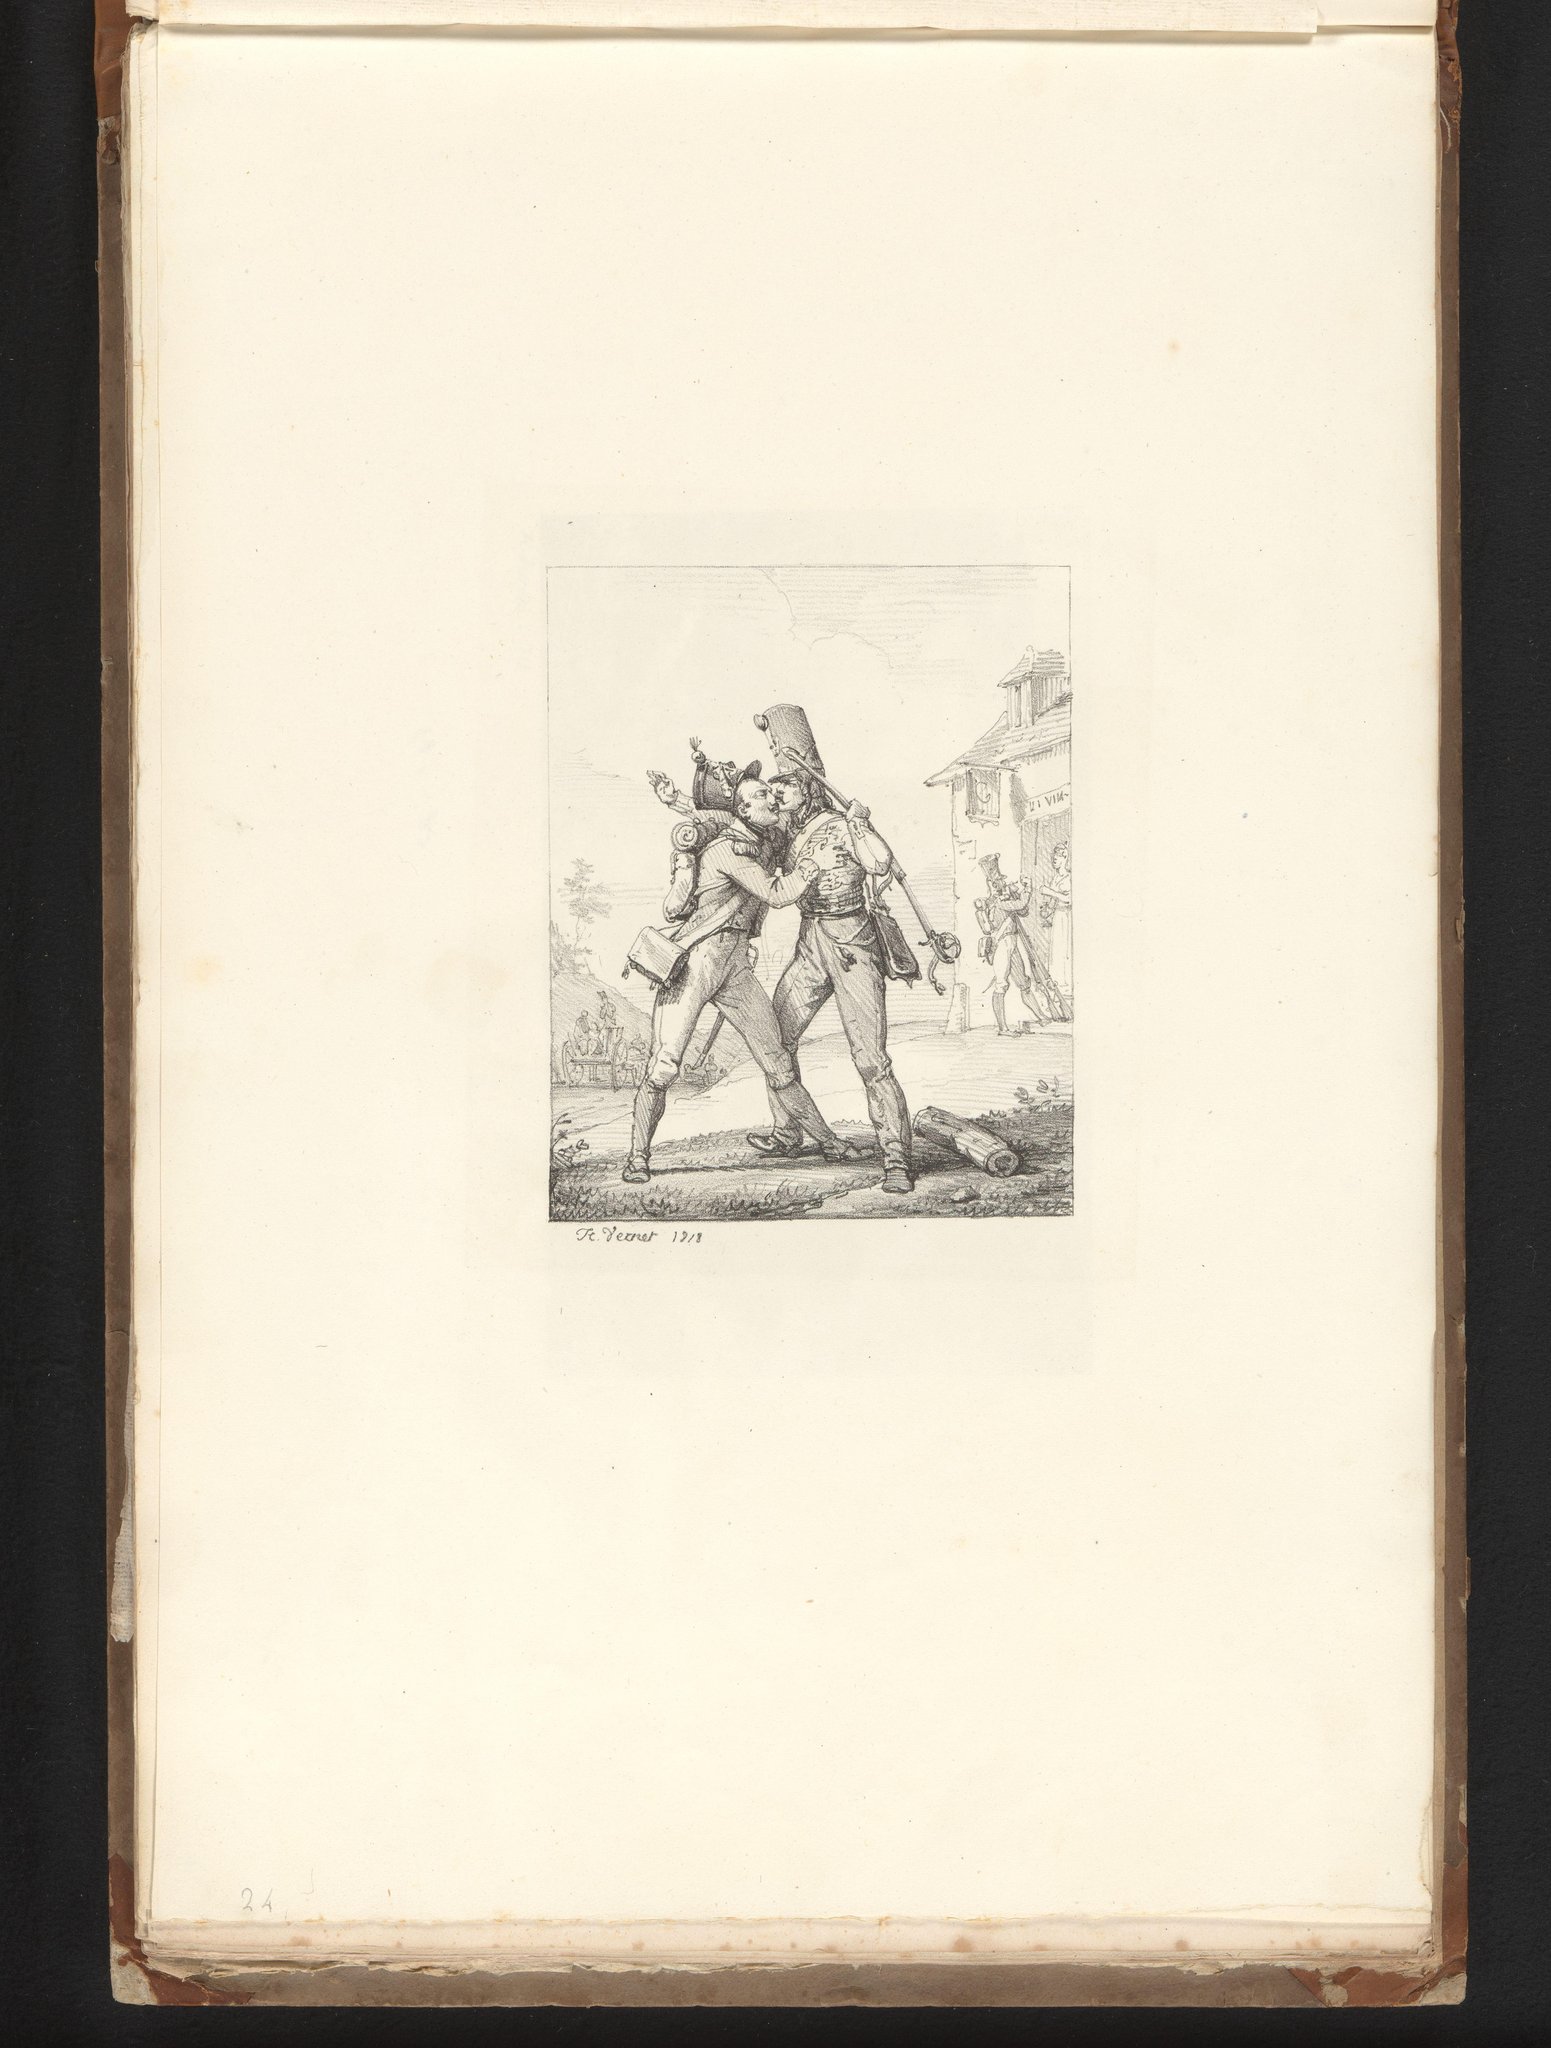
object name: album leaf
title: Serie lithografieën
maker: horace vernet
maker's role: draughtsman, painter, print maker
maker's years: 1789-1863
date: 1818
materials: paper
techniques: lithograph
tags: embracing each other, kissing, drunkenness, the soldier; the soldier's life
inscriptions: date